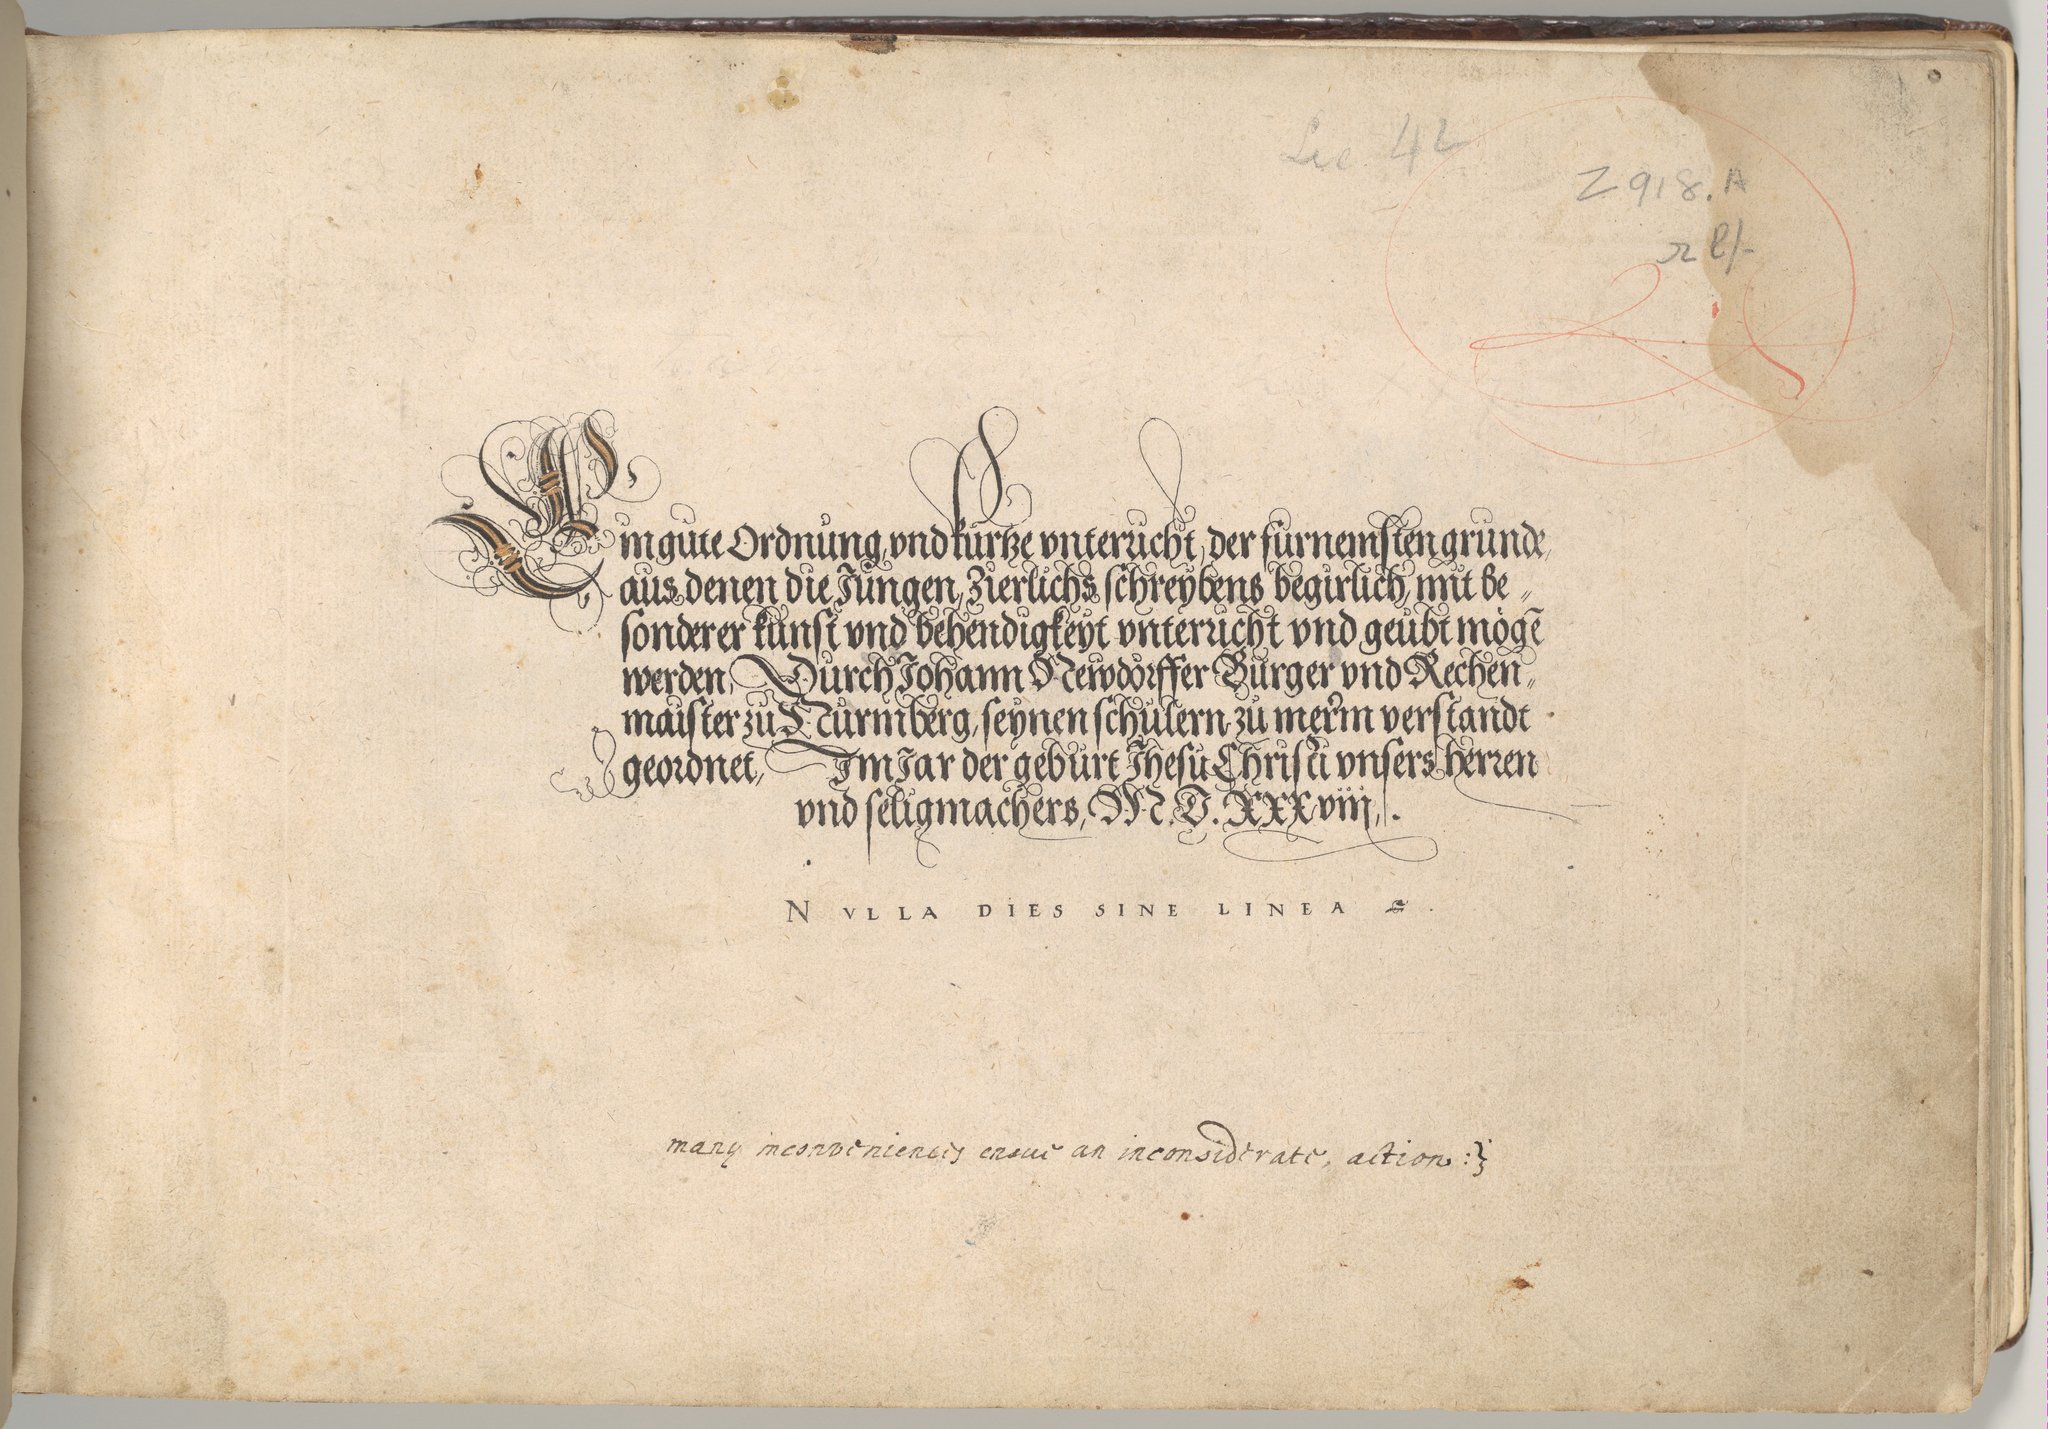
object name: book ornament architectture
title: Writing Book (Eine Gute Ordnung und kurtze unterucht' [sic])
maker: johann neudörffer the elder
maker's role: artist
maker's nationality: german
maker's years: 1497-1563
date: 1538-1541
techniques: etching, hand coloring